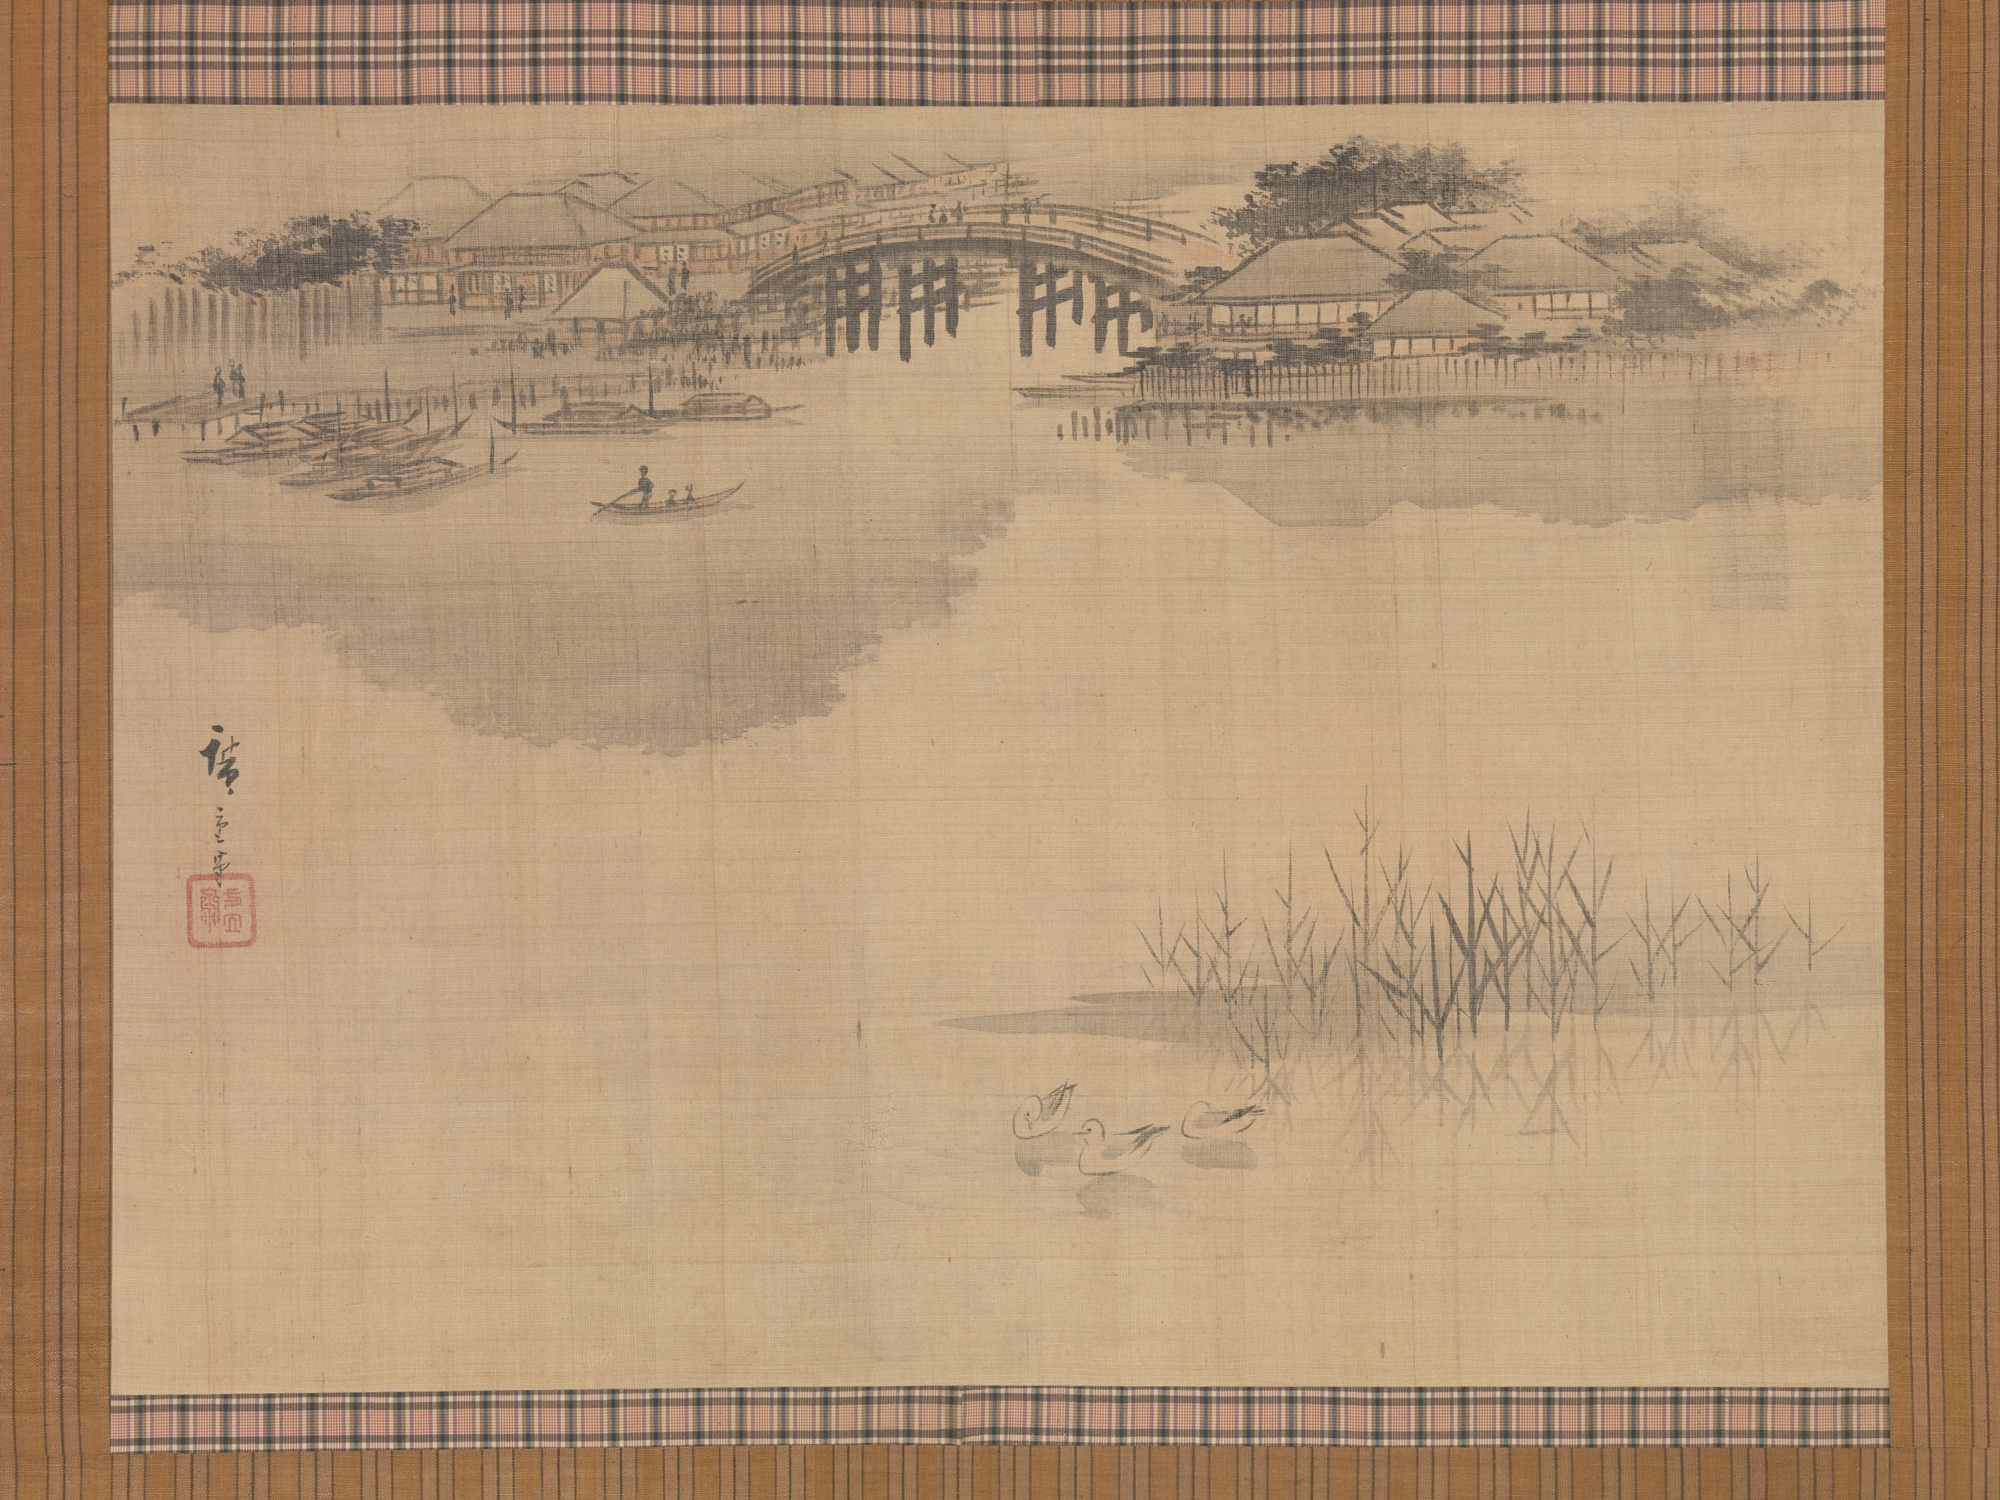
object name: hanging scroll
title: The Imado Bridge at the Foot of Mount Matsuchi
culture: japanese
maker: utagawa hiroshige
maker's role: artist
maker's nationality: japanese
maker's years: 1797-1858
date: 1801-1833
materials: ink, silk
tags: bridges,rivers,boats